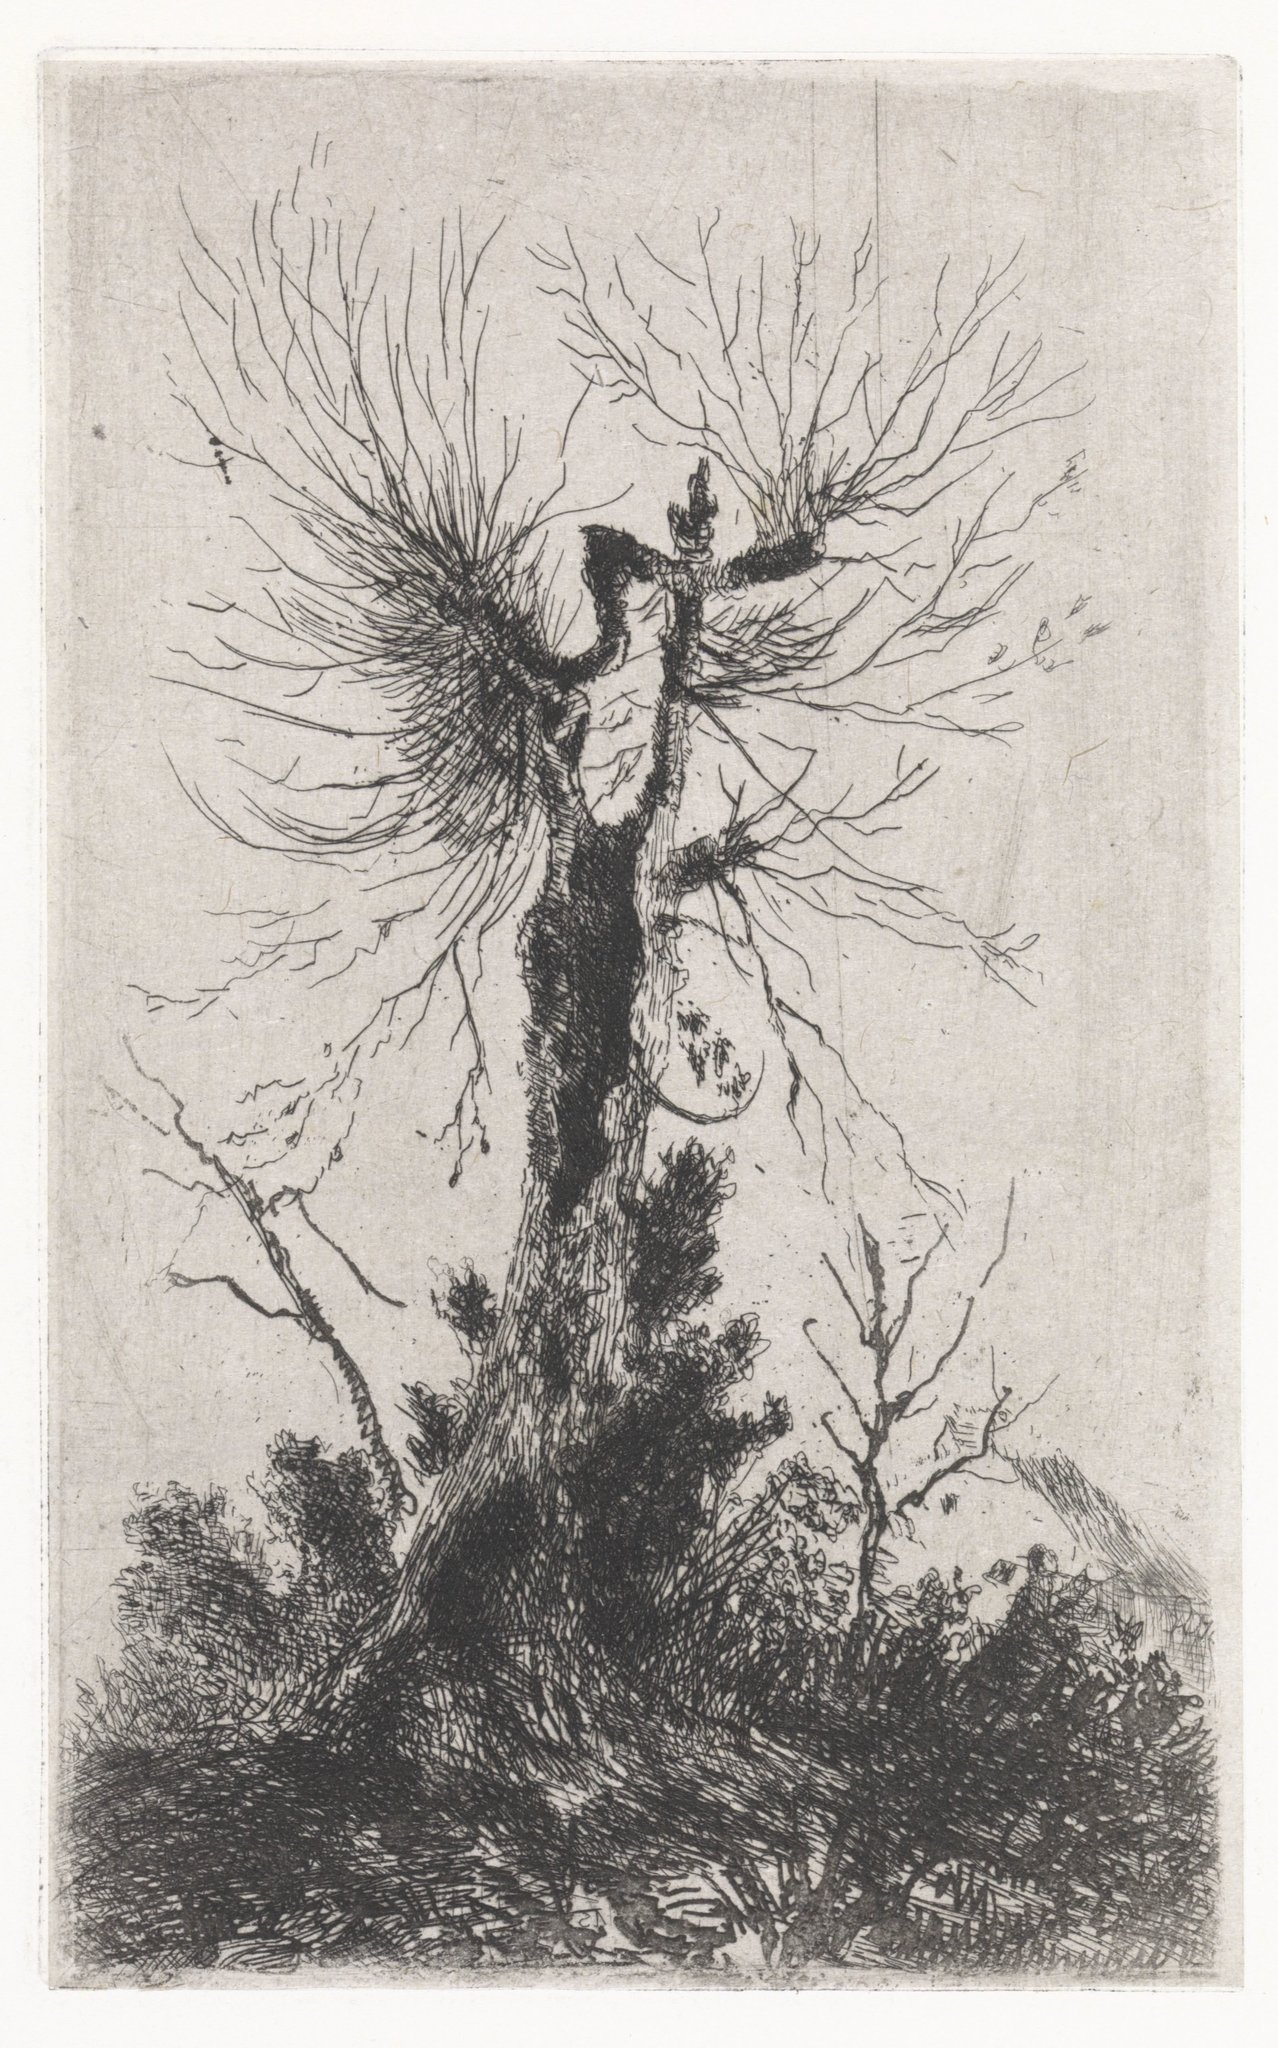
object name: print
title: Boomstudie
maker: arnoud schaepkens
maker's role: print maker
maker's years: 1816-1904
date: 1855-1904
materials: paper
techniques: drypoint, etching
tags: trees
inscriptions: collector's mark: Lugt 2228